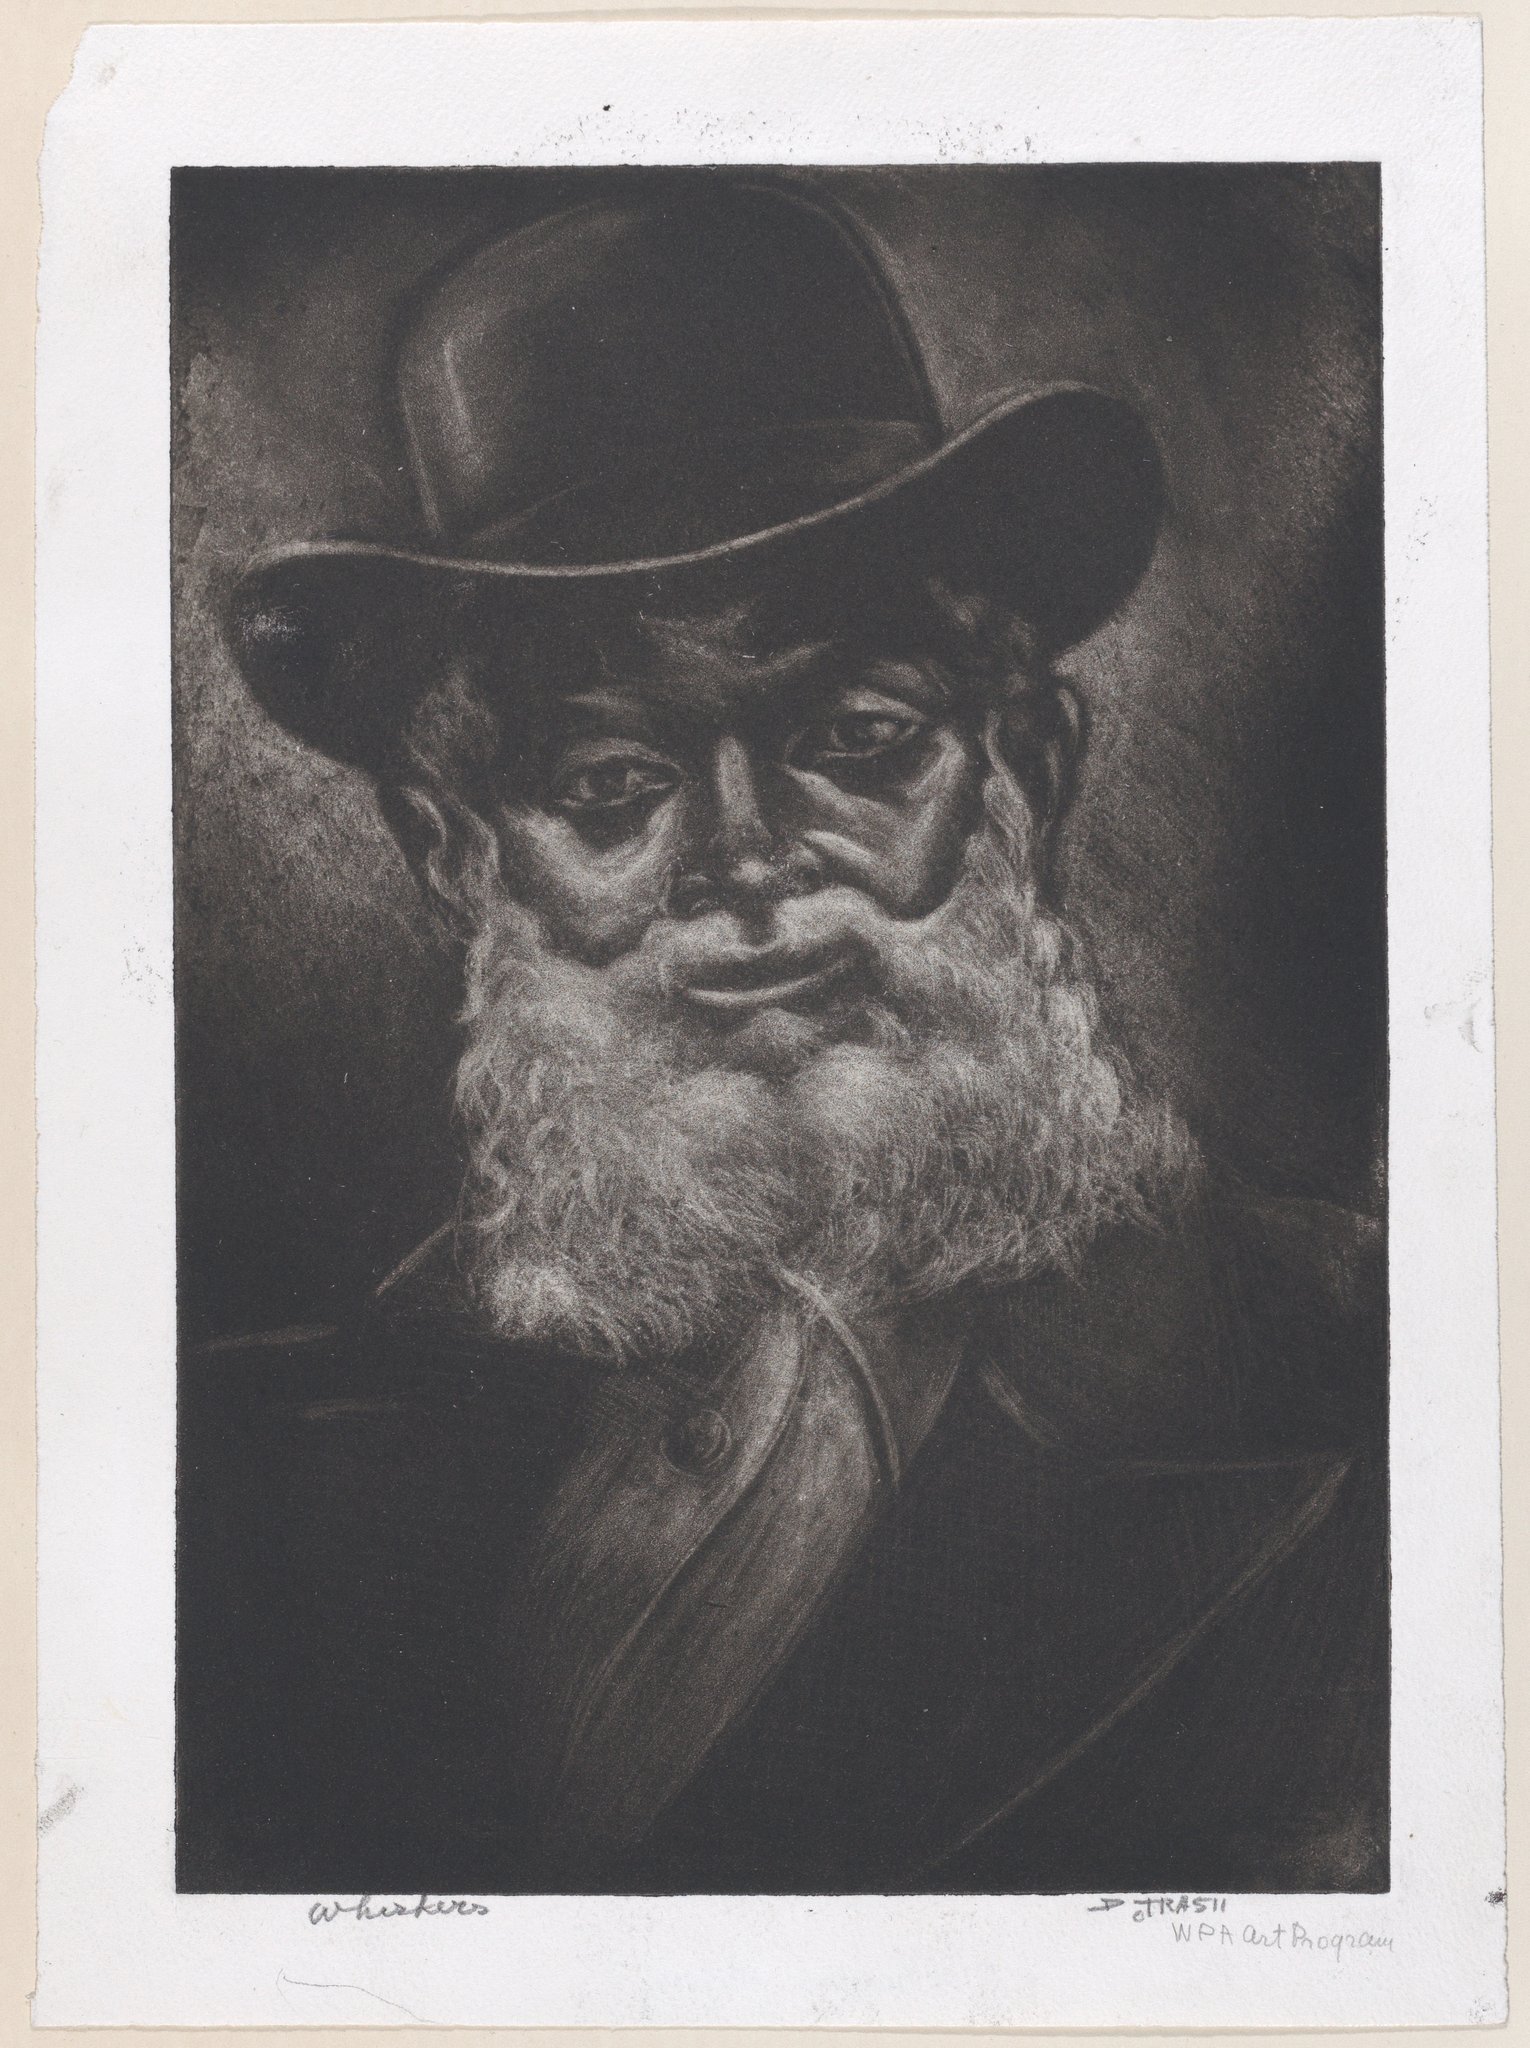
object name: print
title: Whiskers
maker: dox thrash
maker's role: artist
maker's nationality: american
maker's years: 1893-1965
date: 1939-1940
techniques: mezzotint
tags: men